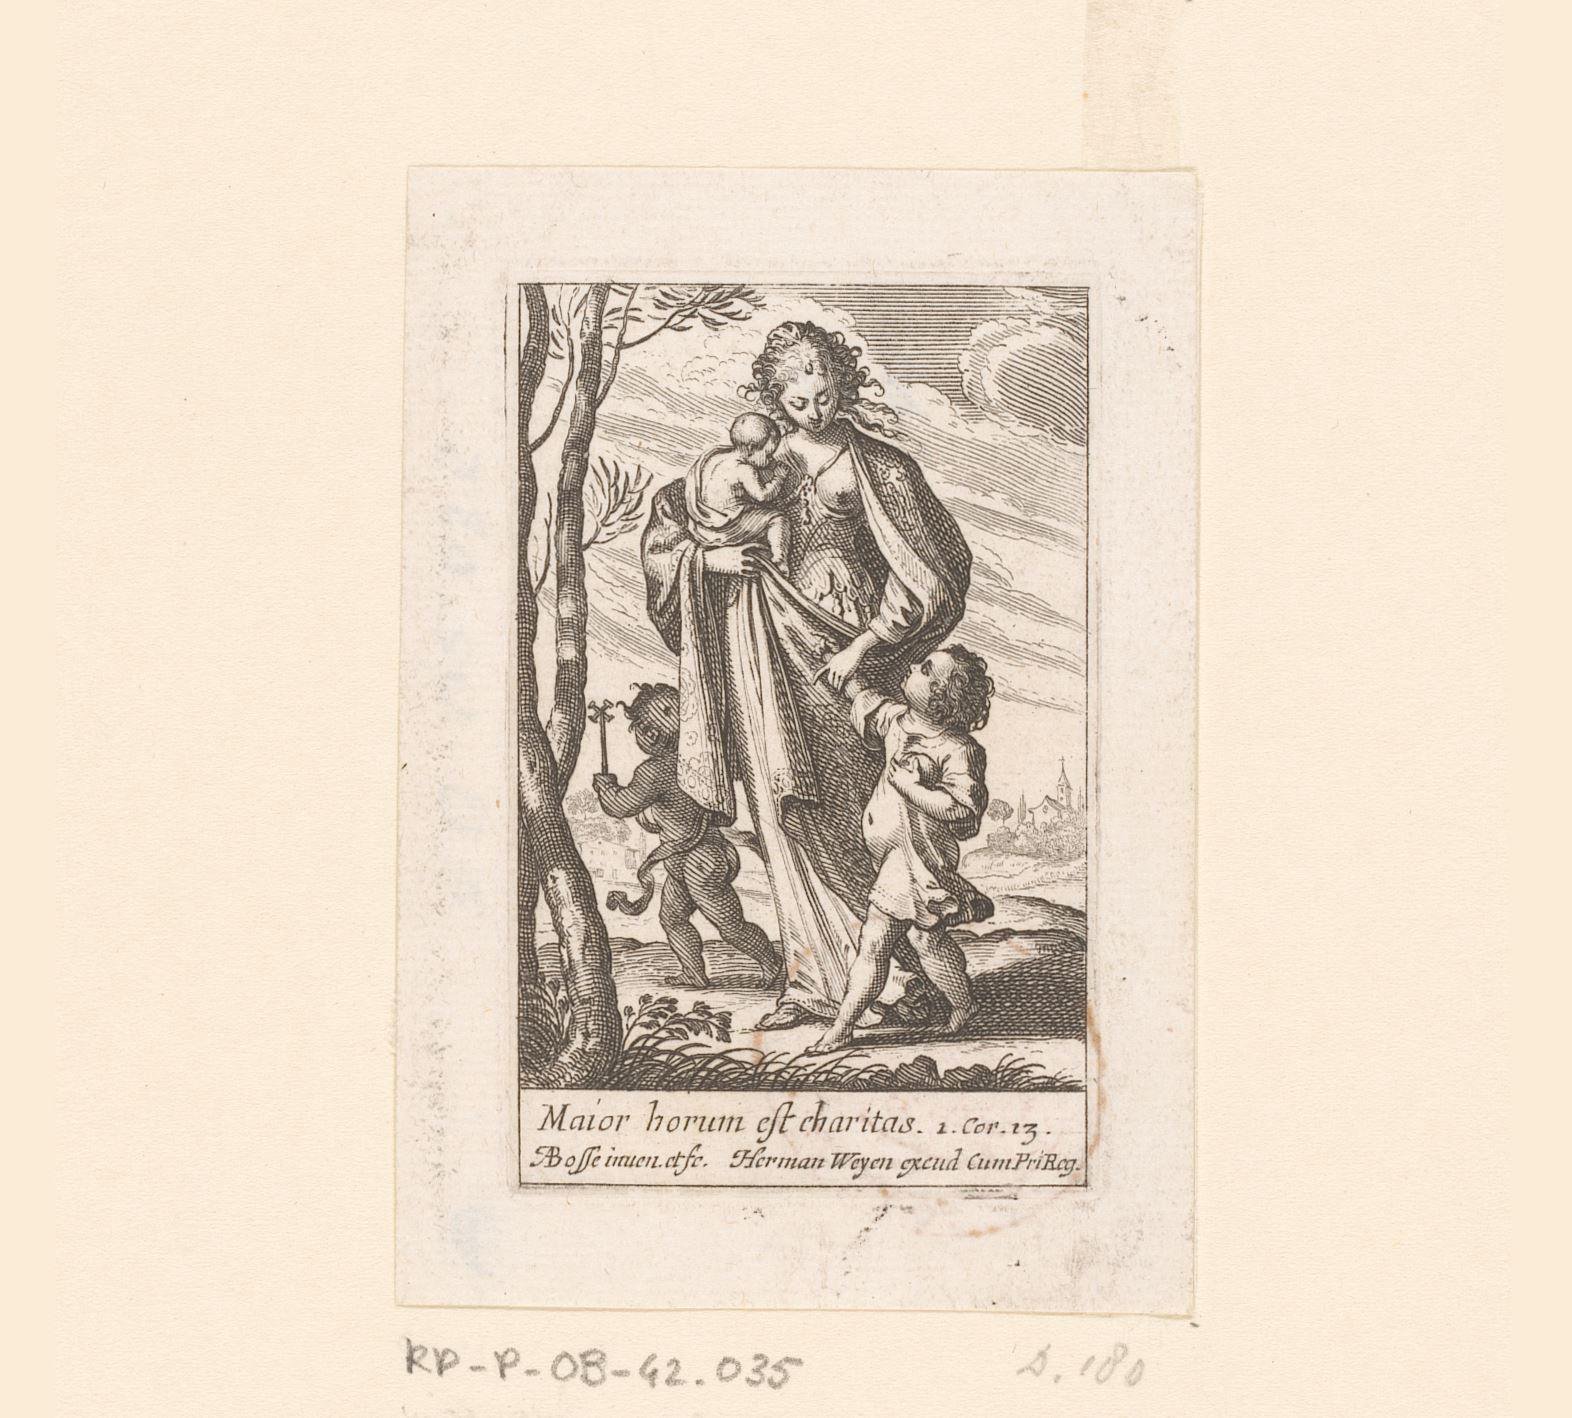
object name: print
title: Personificaties van deugden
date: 1636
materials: paper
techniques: engraving, etching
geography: paris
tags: charity, 'caritas'; 'carità' (ripa) ~ one of the three theological virtues, the seven virtues (symbolized)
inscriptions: collector's mark: Lugt 240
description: Maakt deel uit van een serie van negen prenten (inclusief twee titelprenten) met personificaties van de zeven deugden.